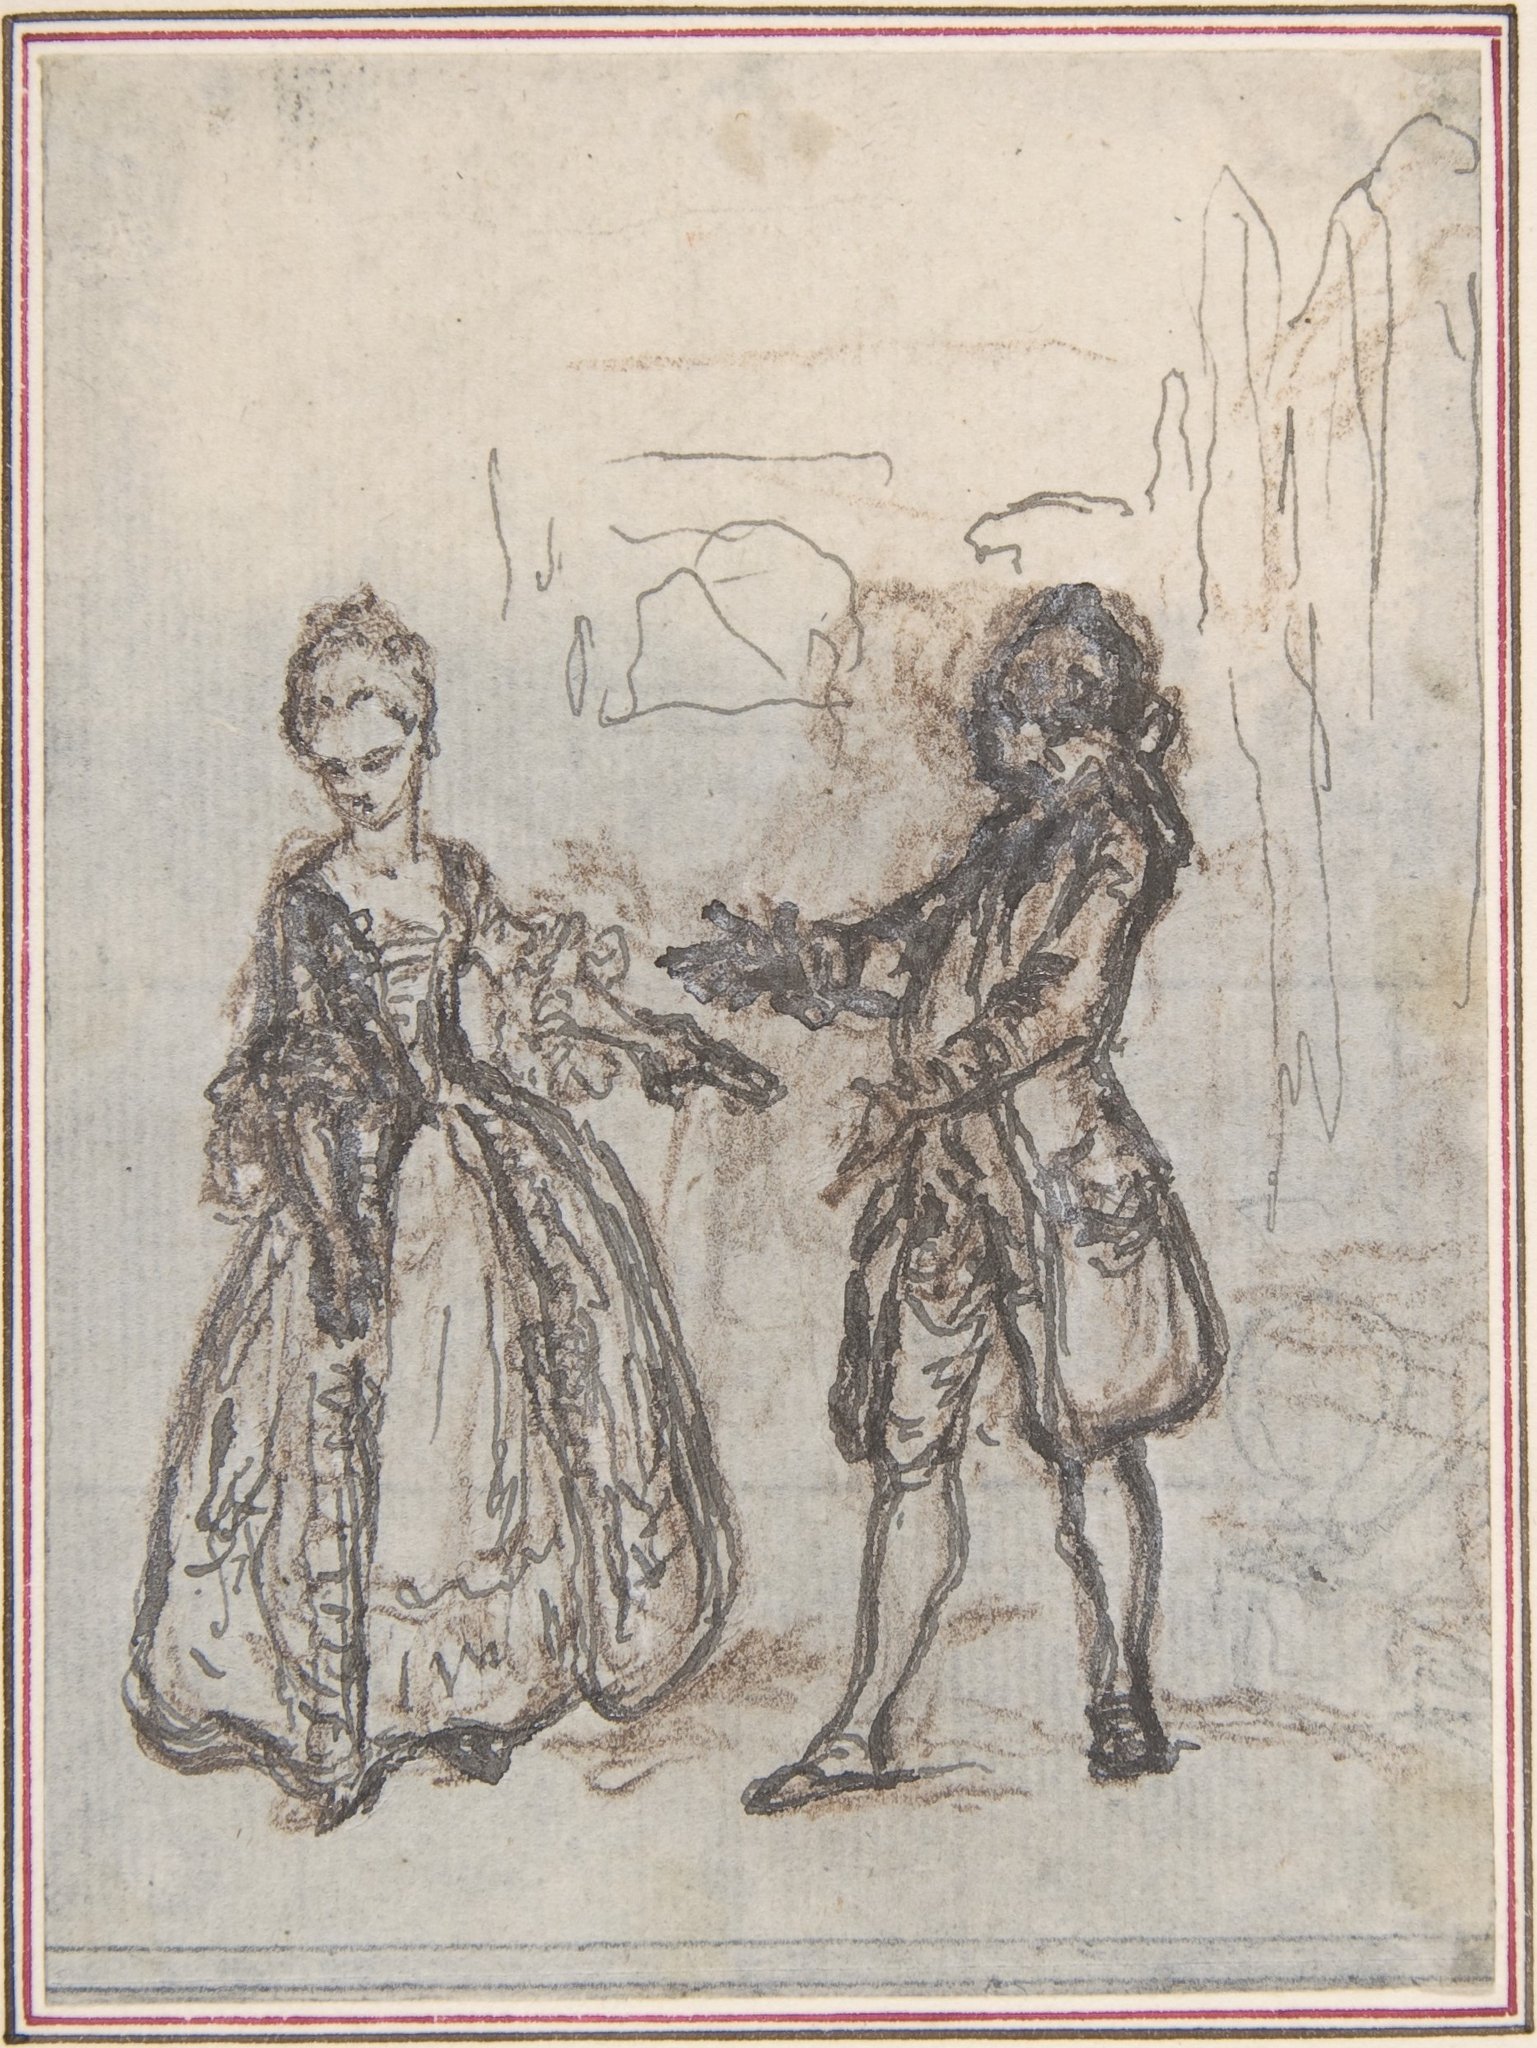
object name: drawing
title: Design for a Scene in Pierre de Laujon's "L'Amoureux de quinze ans, ou la Double-Fête..."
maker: hubert françois gravelot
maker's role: artist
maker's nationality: french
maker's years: 1699-1773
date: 1771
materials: chalk, ink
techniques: pen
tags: men,lovers,women